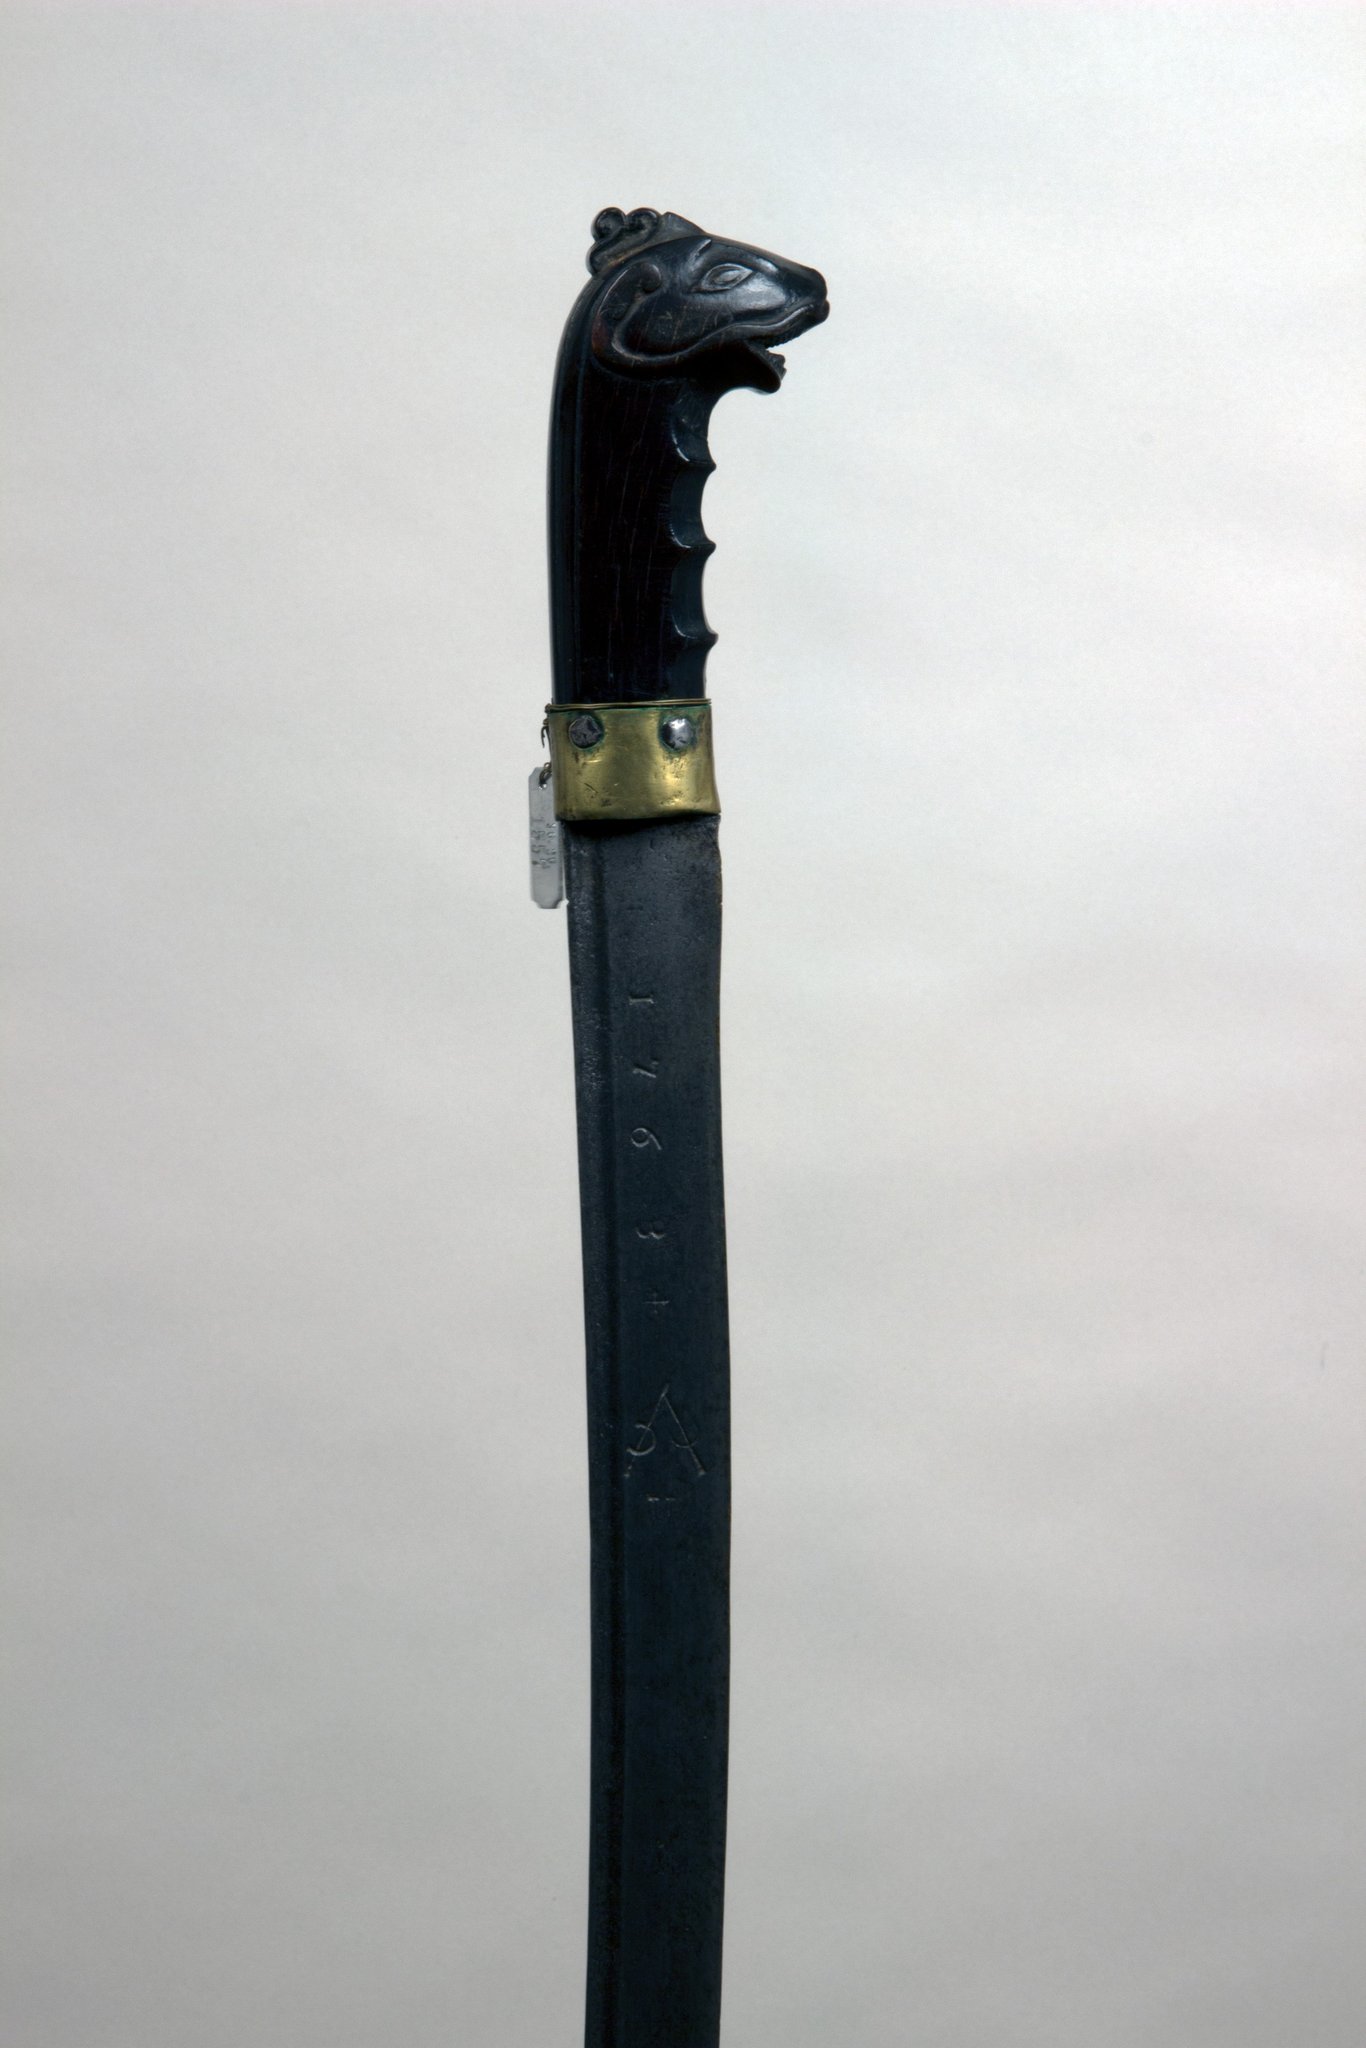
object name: sword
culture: sri lankan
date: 1701-1900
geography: sri lanka